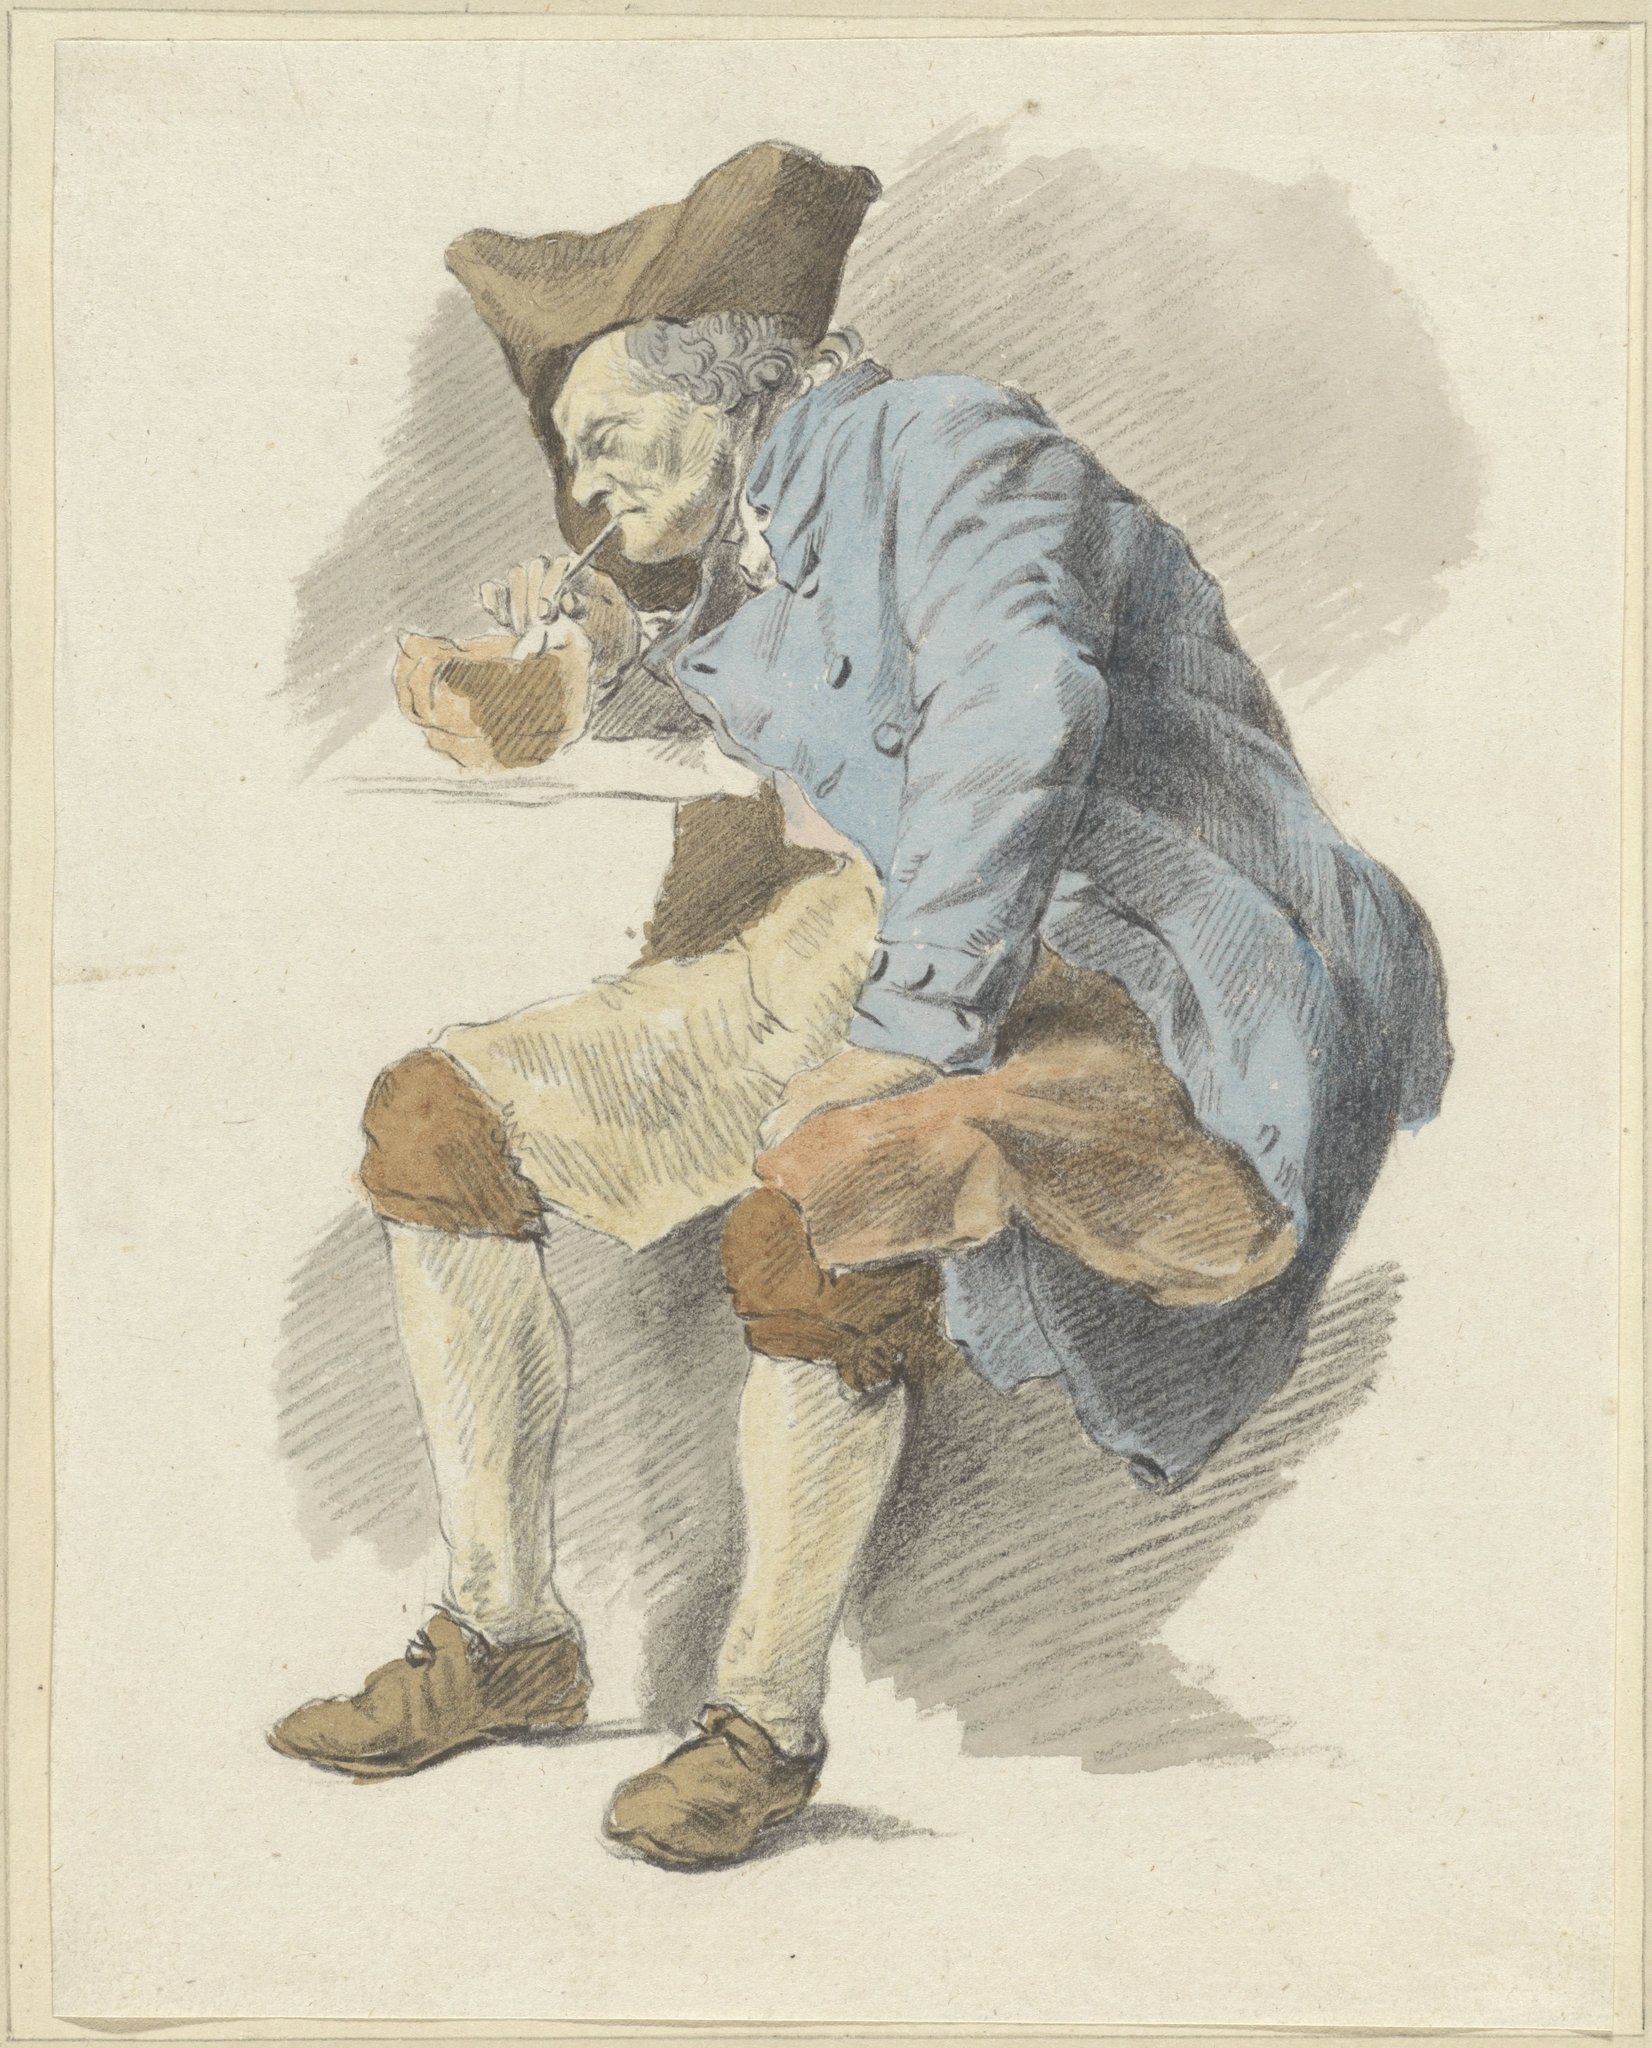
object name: watercolor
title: Zittende man steekt zijn pijp aan een test aan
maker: woutherus mol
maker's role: draughtsman, painter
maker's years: 1785-1857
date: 1795-1857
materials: chalk, paper, watercolor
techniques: brush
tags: pipe ~ tobacco (+ taking (particular) foodstuffs: eating, drinking, smoking, chewing, etc.)